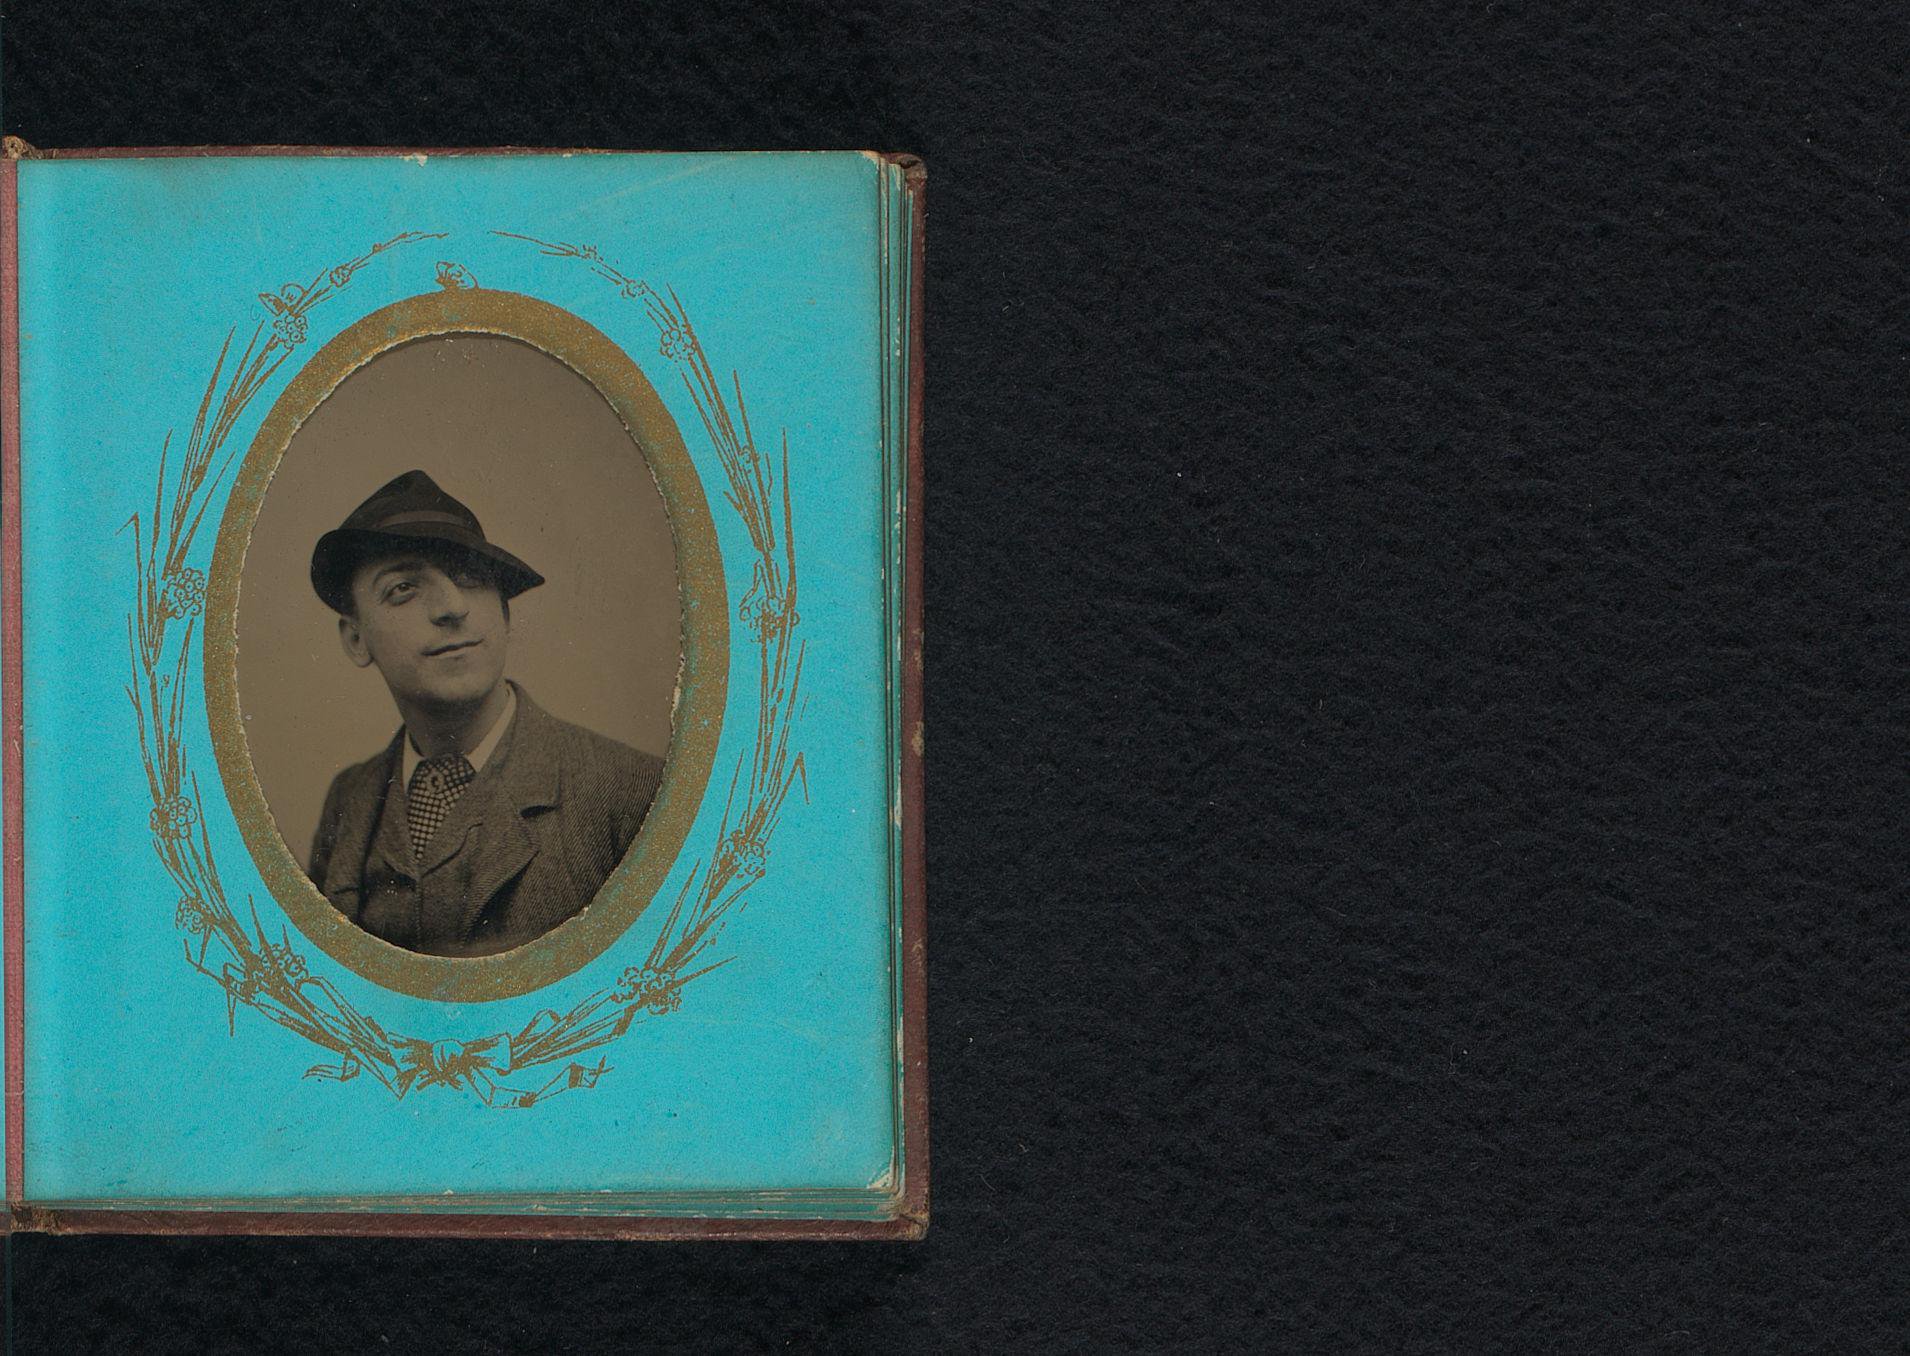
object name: album leaf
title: Portret van een man met pet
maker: Anonymous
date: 1855-1900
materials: iron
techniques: ferrotyping, hand coloring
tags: historical persons not known by name